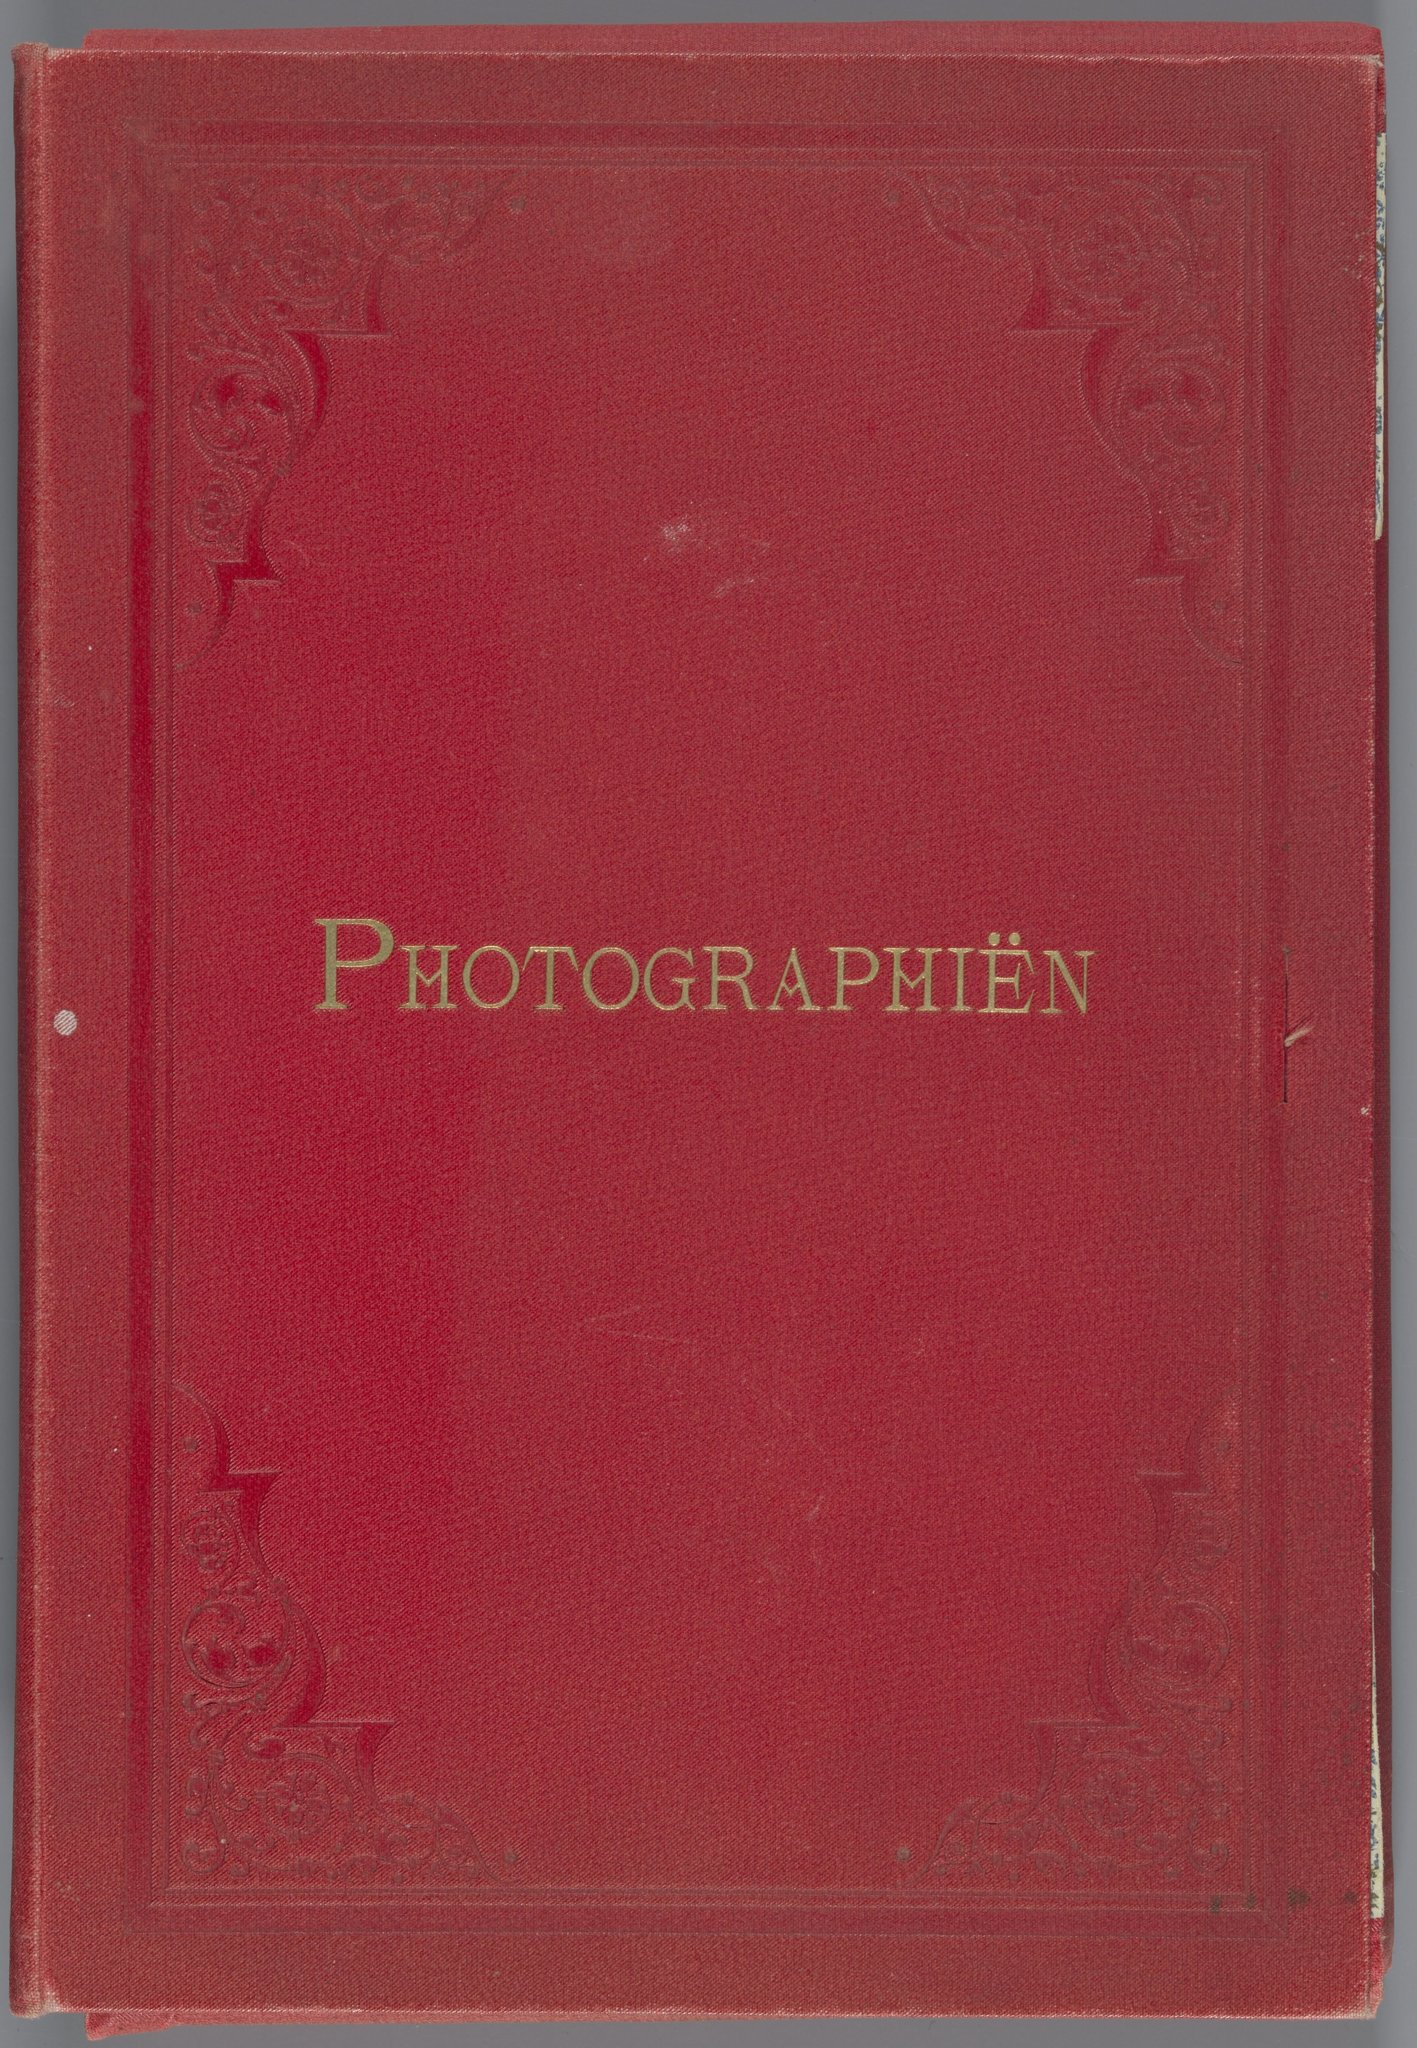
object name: wrapper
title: Hansje, the Photographer’s Daughter, with a Boy at the Beach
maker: willem de jong (fotograaf)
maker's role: arts, fotograaf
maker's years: 1864-1918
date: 1897-1899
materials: cardboard, linen, paper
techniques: decorated paper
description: Omslag bevat ook een lijst met bijschriften.